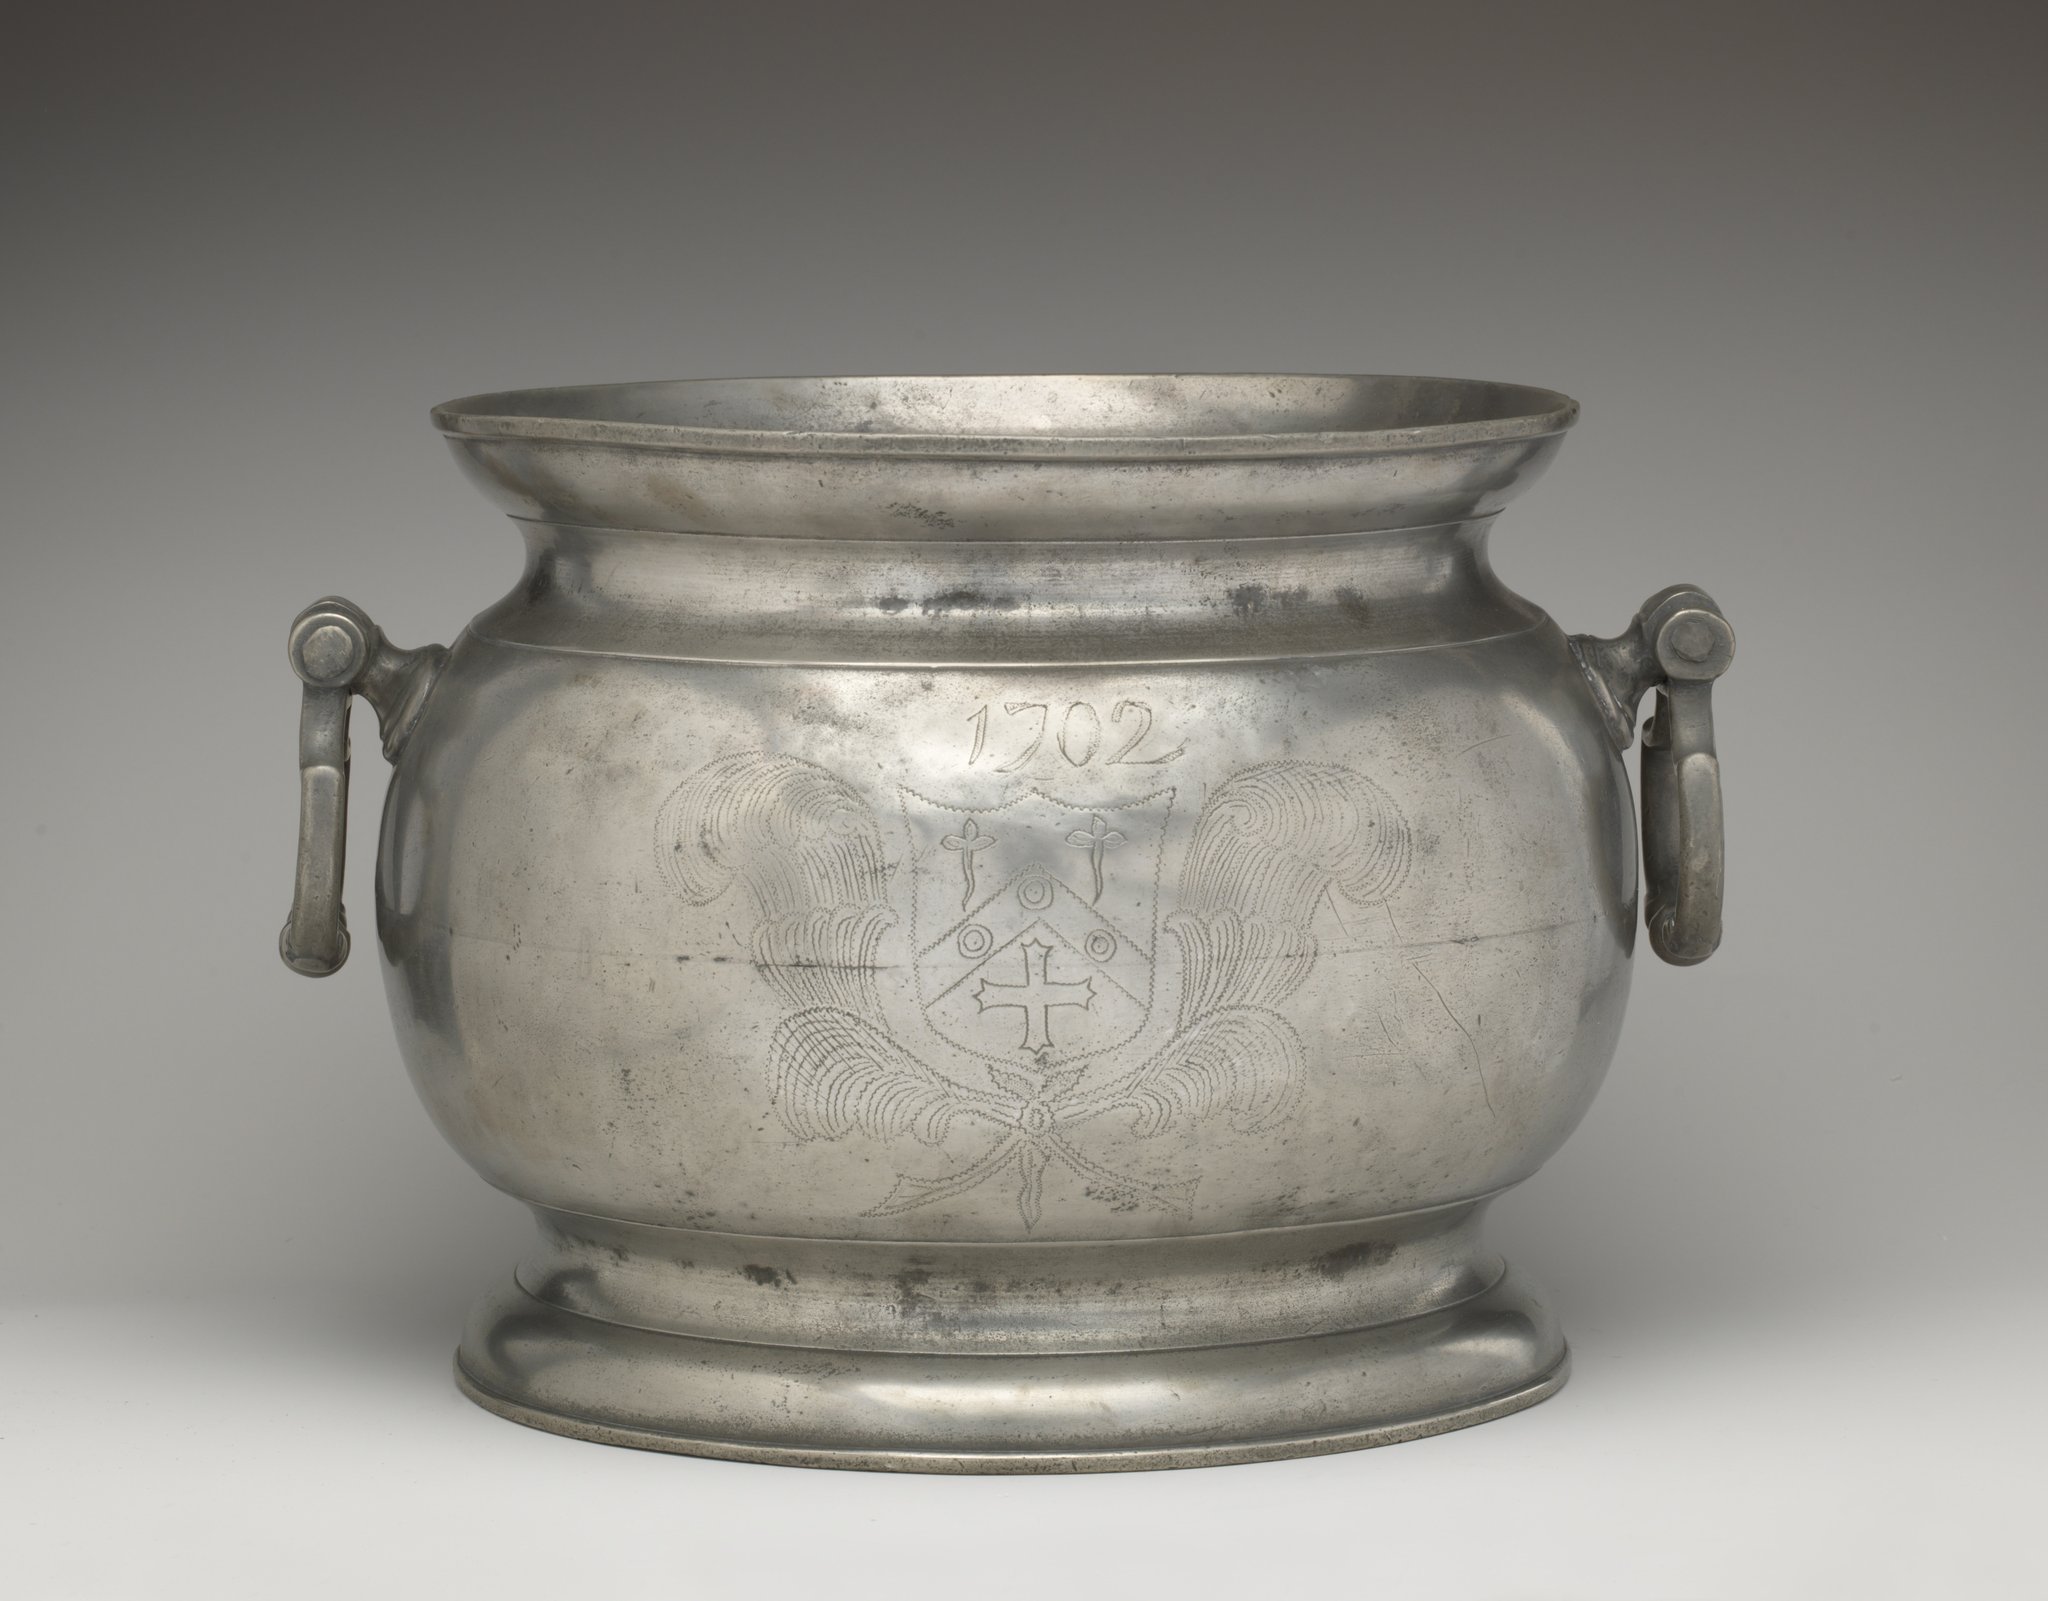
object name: punch bowl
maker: william eddon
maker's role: maker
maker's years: 1650-1750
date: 1702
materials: pewter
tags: coat of arms